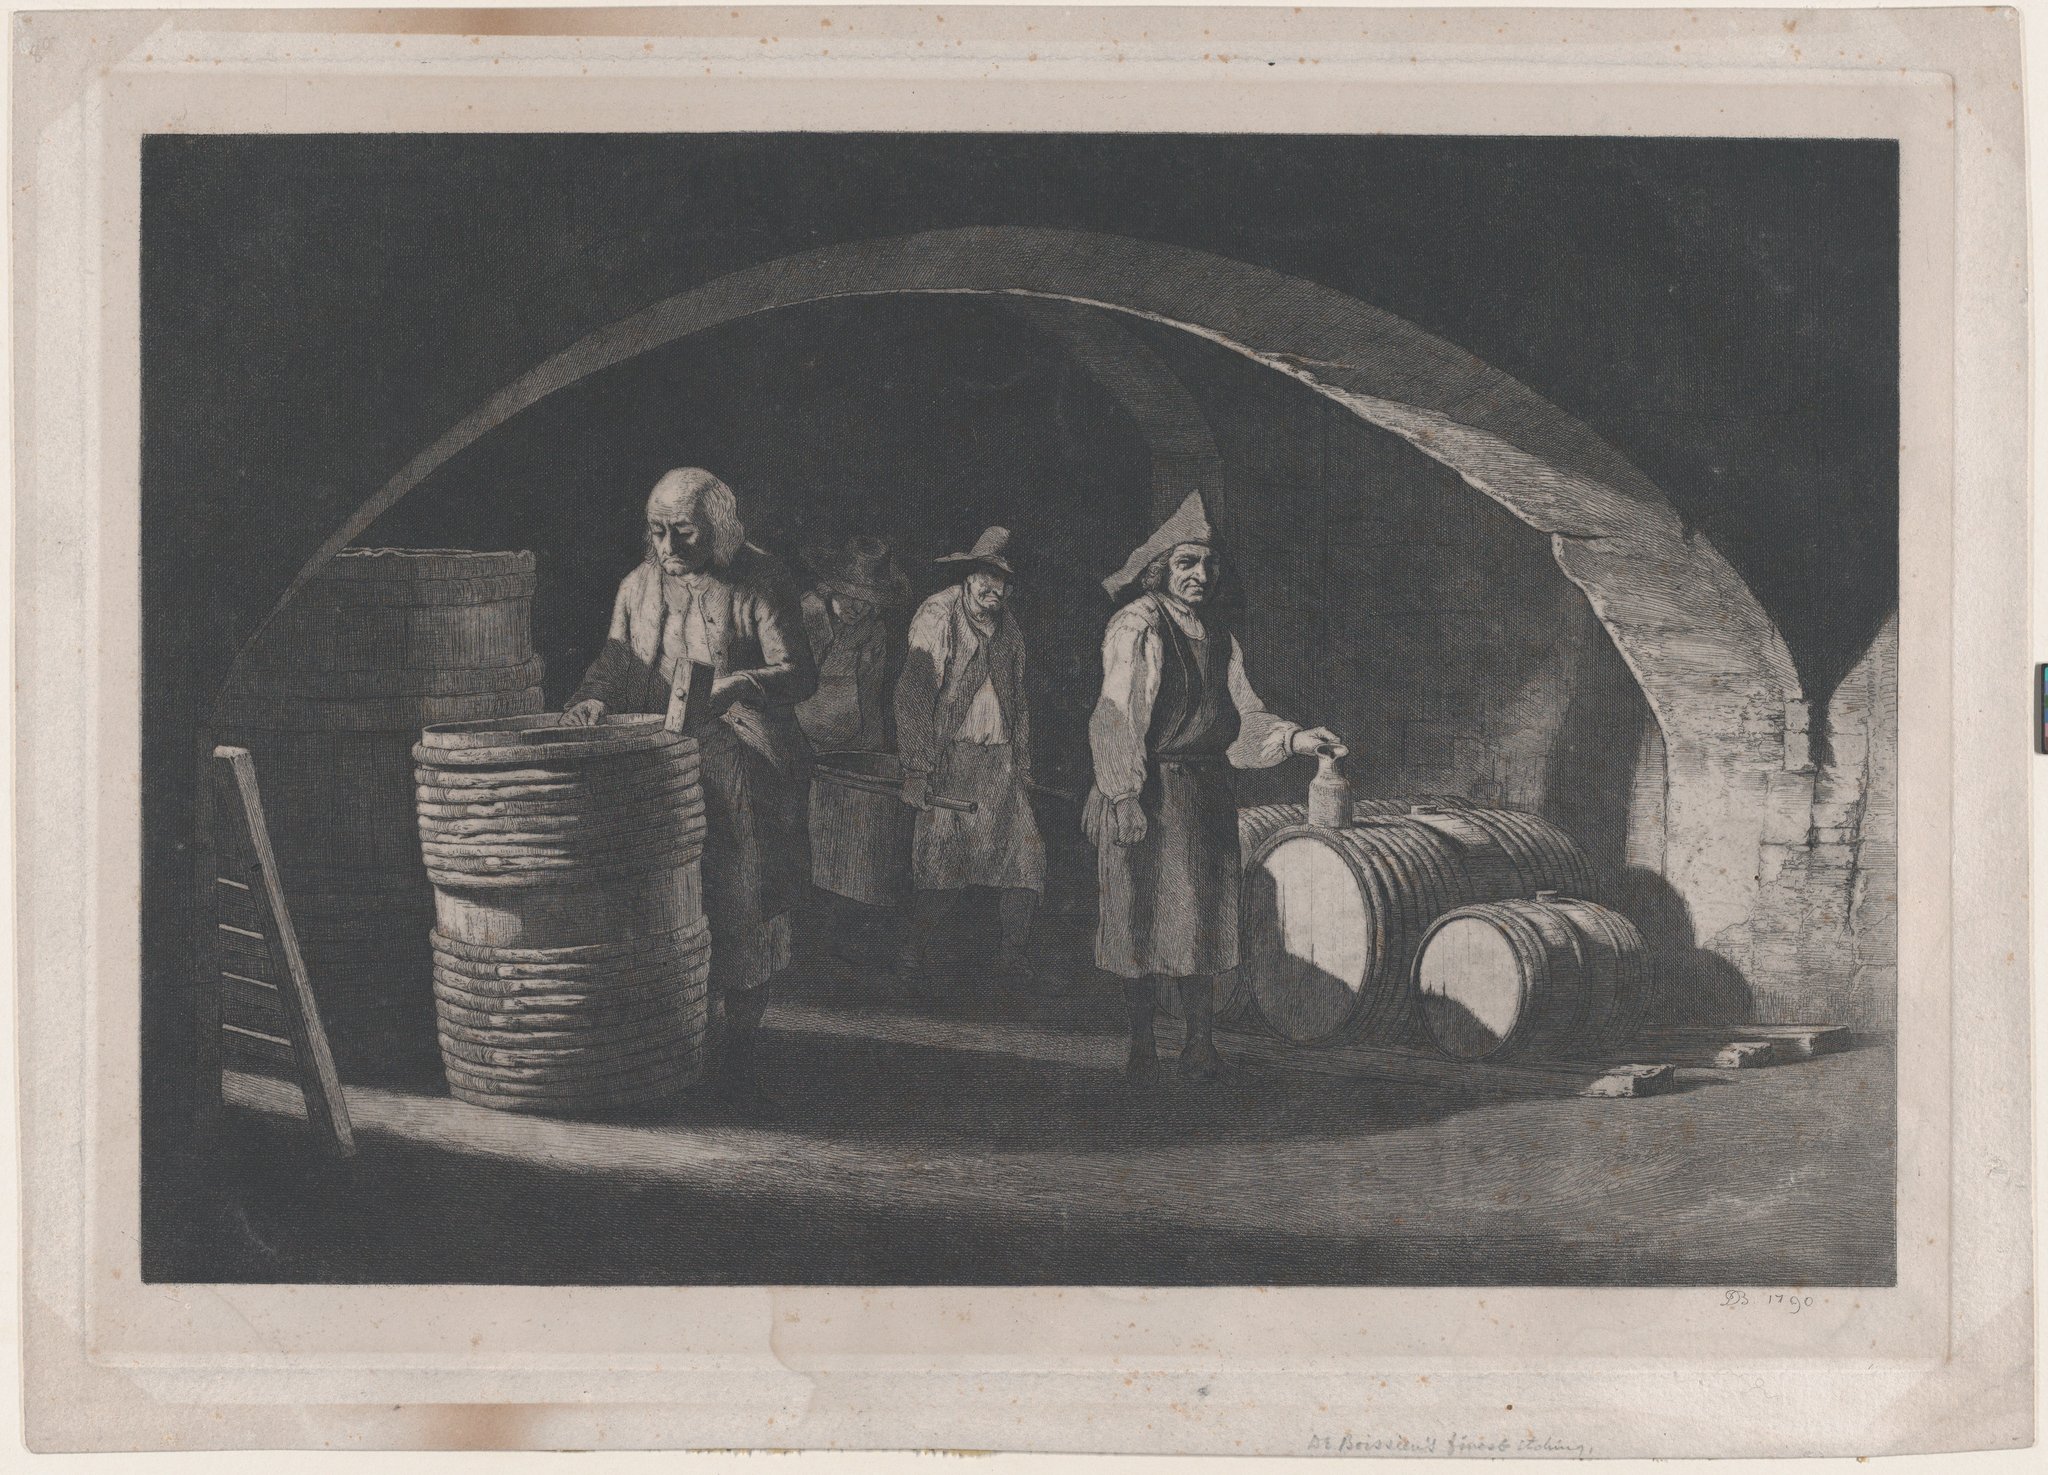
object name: print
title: The Coopers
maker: jean jacques de boissieu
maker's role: artist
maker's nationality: french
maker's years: 1736-1810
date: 1790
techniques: drypoint, etching, roulette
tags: men,barrels